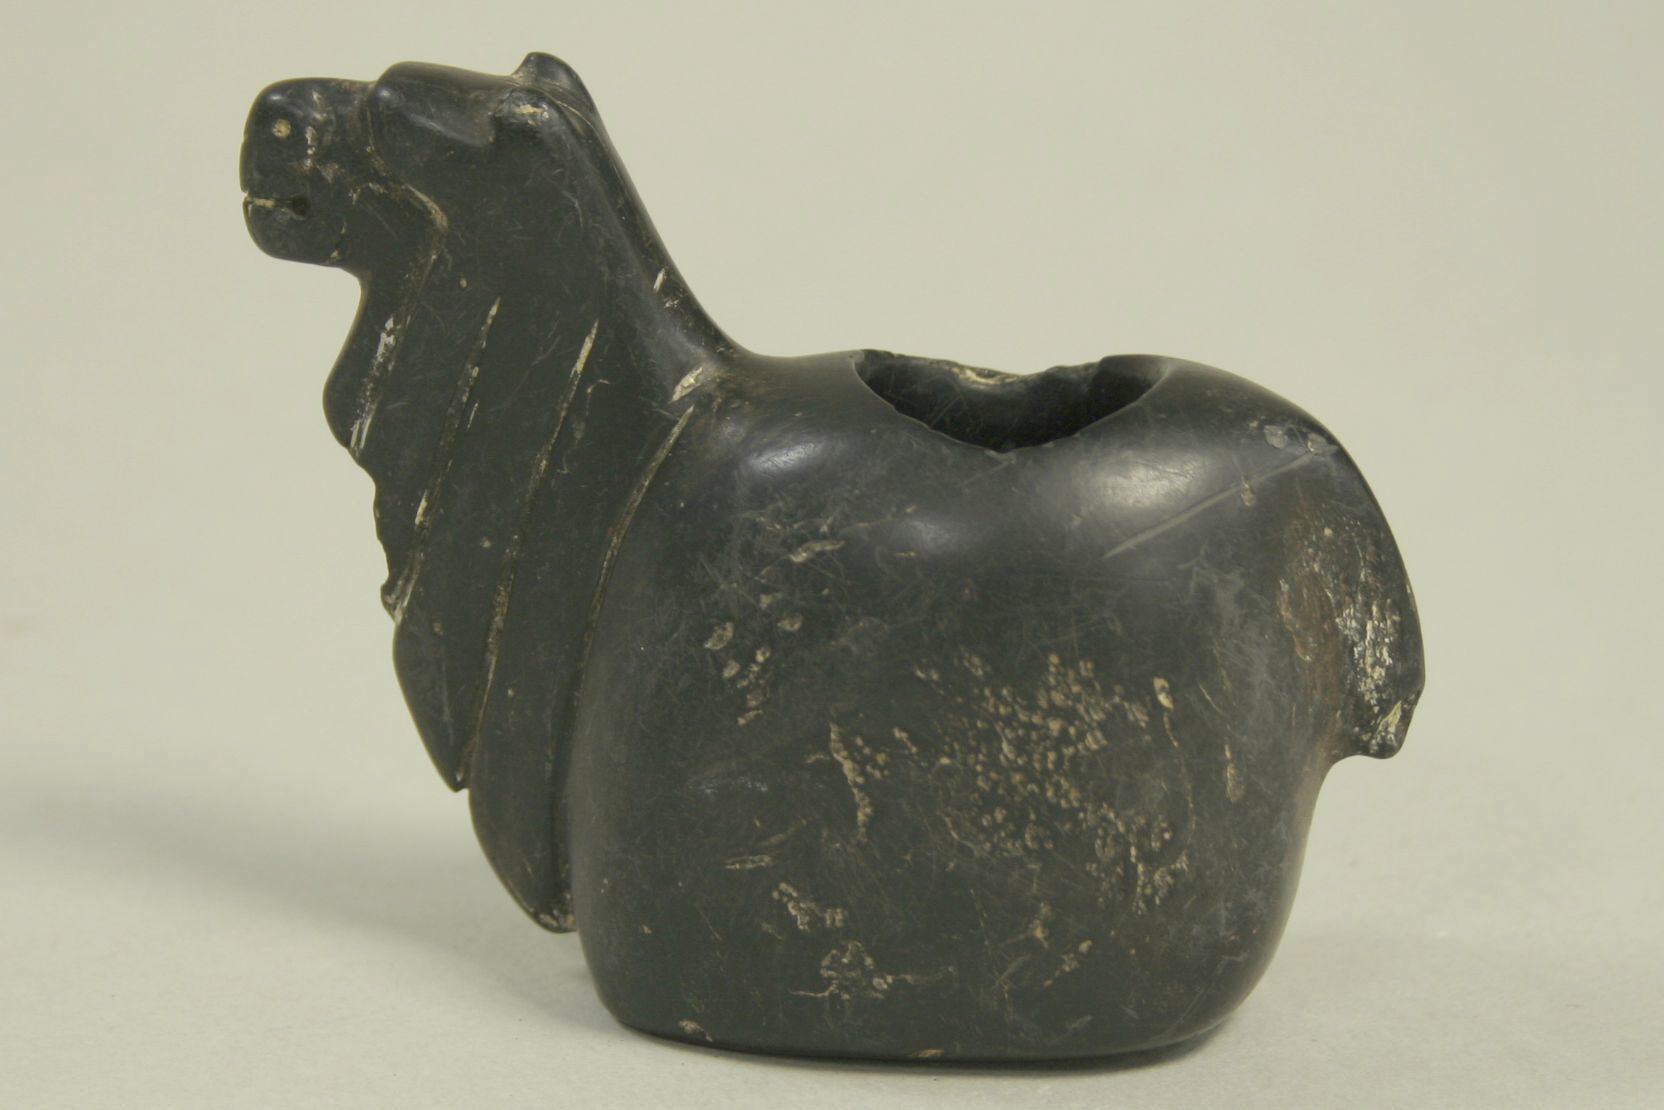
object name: vessel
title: Votive Container (Canopa)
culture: inca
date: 1401-1600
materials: stone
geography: peru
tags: animals